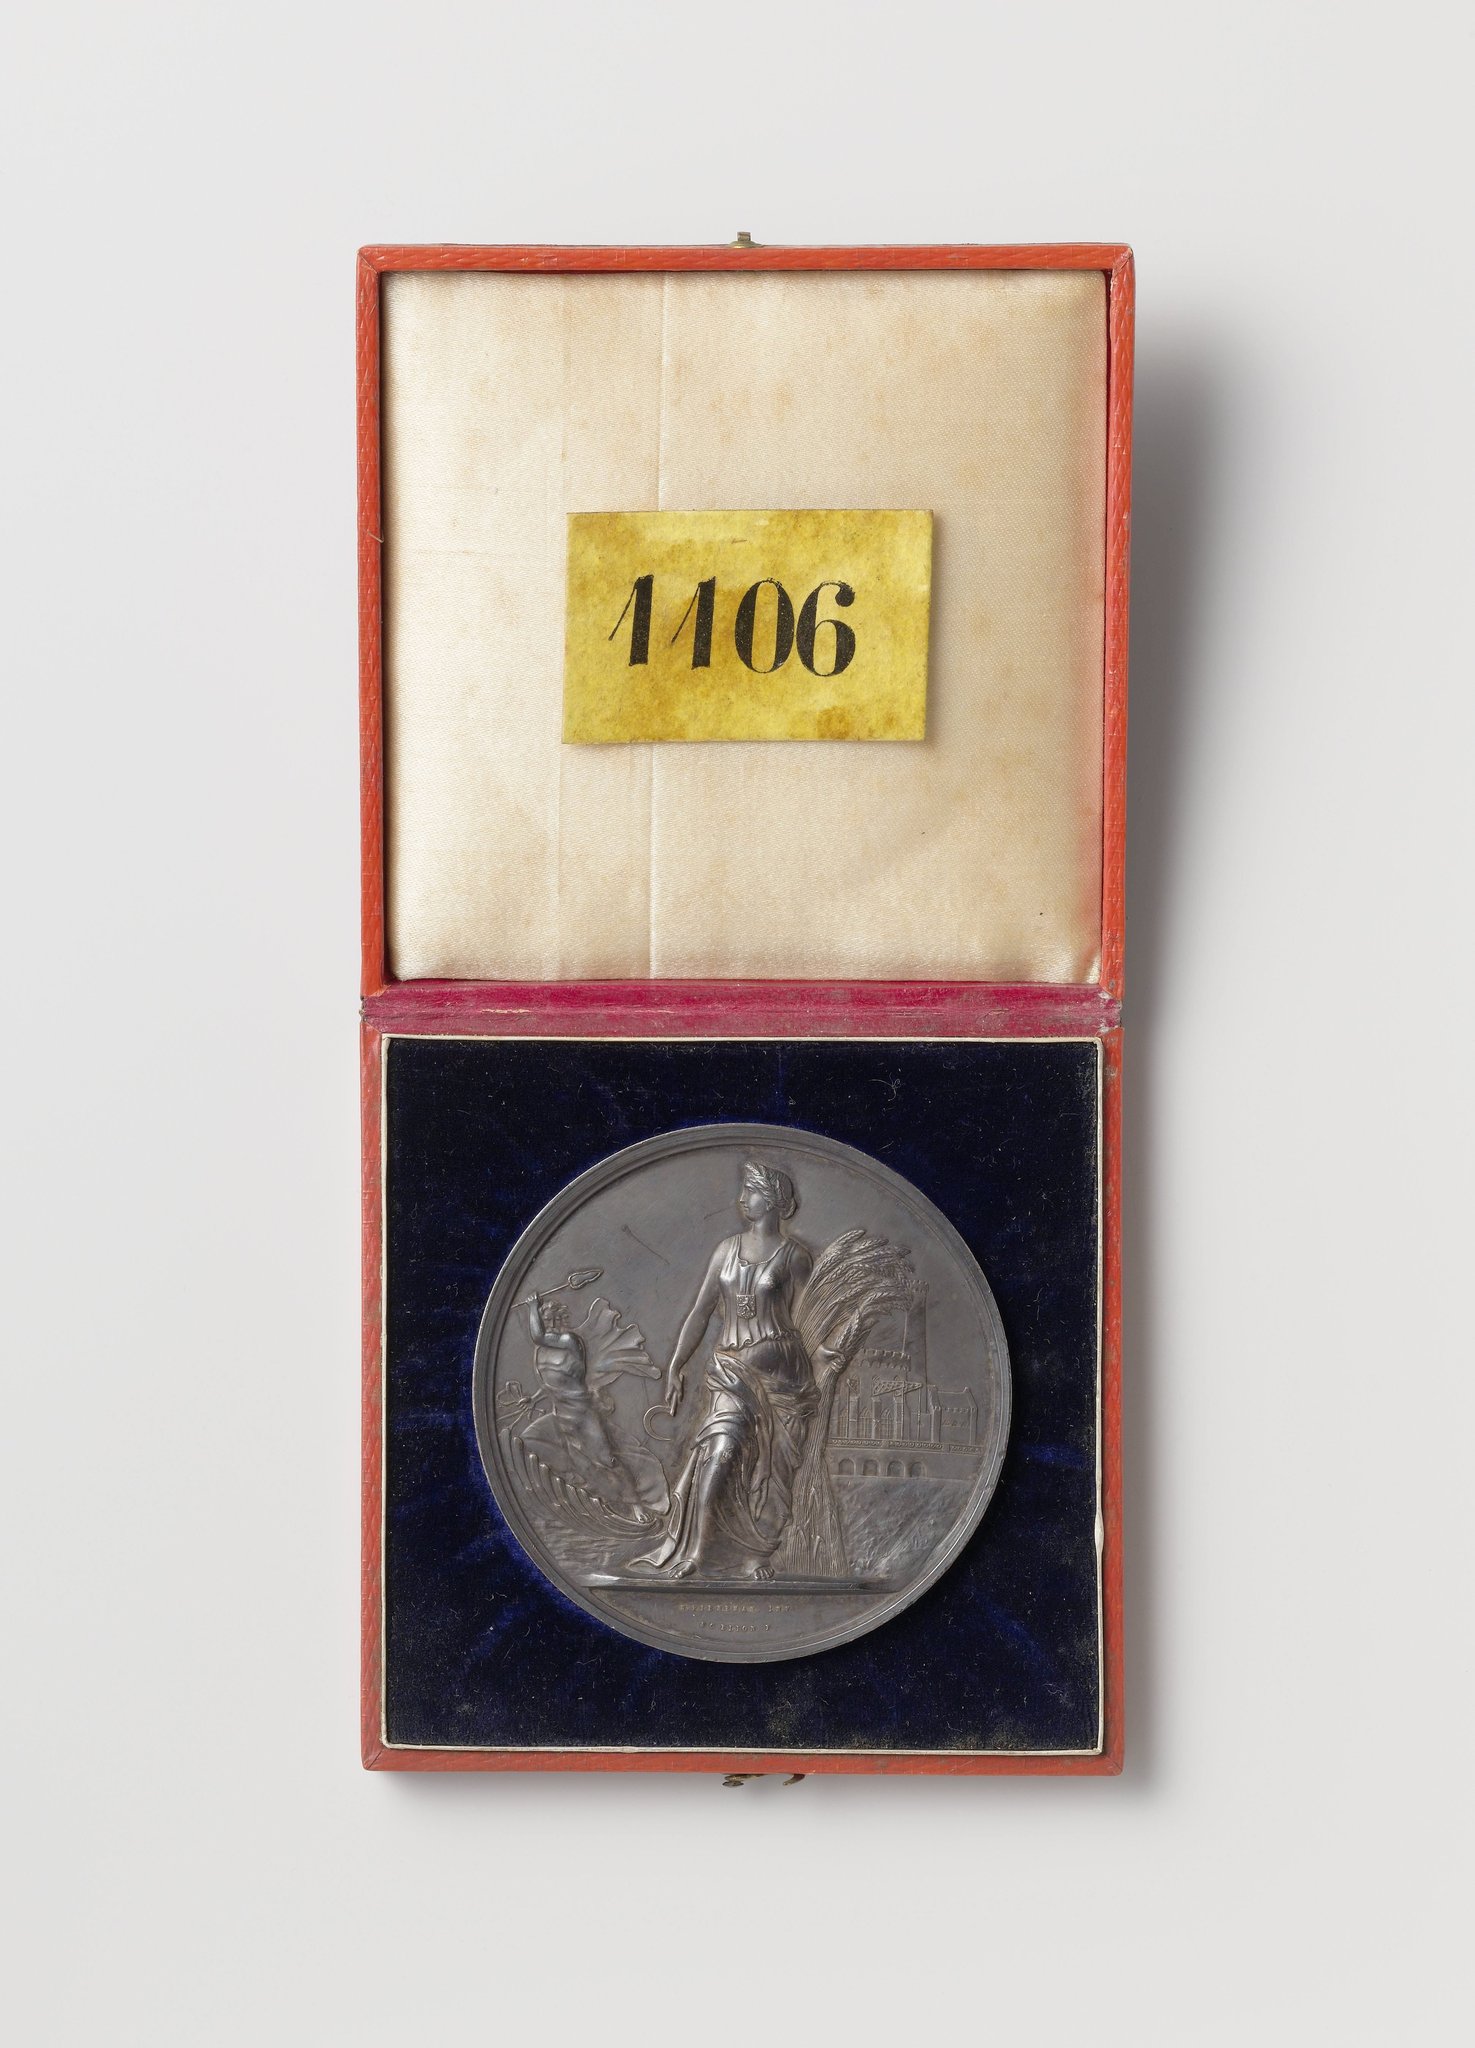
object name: medal box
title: Box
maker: Anonymous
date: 1853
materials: leather, velvet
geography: netherlands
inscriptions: label, on the inside of the lid: ‘1106’ former inventory label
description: Vierkant rood leren doosje met gouden opdruk.